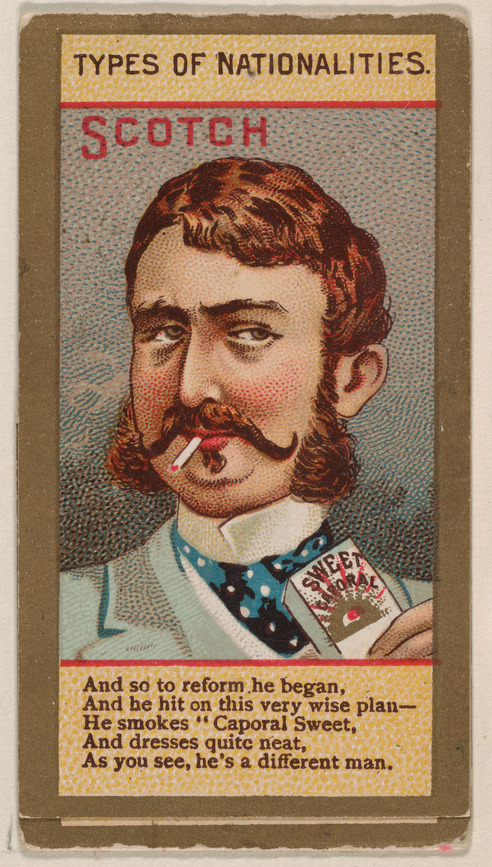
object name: print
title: Scotch, from Types of Nationalities (N240) issued by Kinney Bros.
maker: kinney brothers tobacco company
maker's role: publisher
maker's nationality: american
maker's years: 1869-2011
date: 1890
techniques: color lithograph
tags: men,smoking